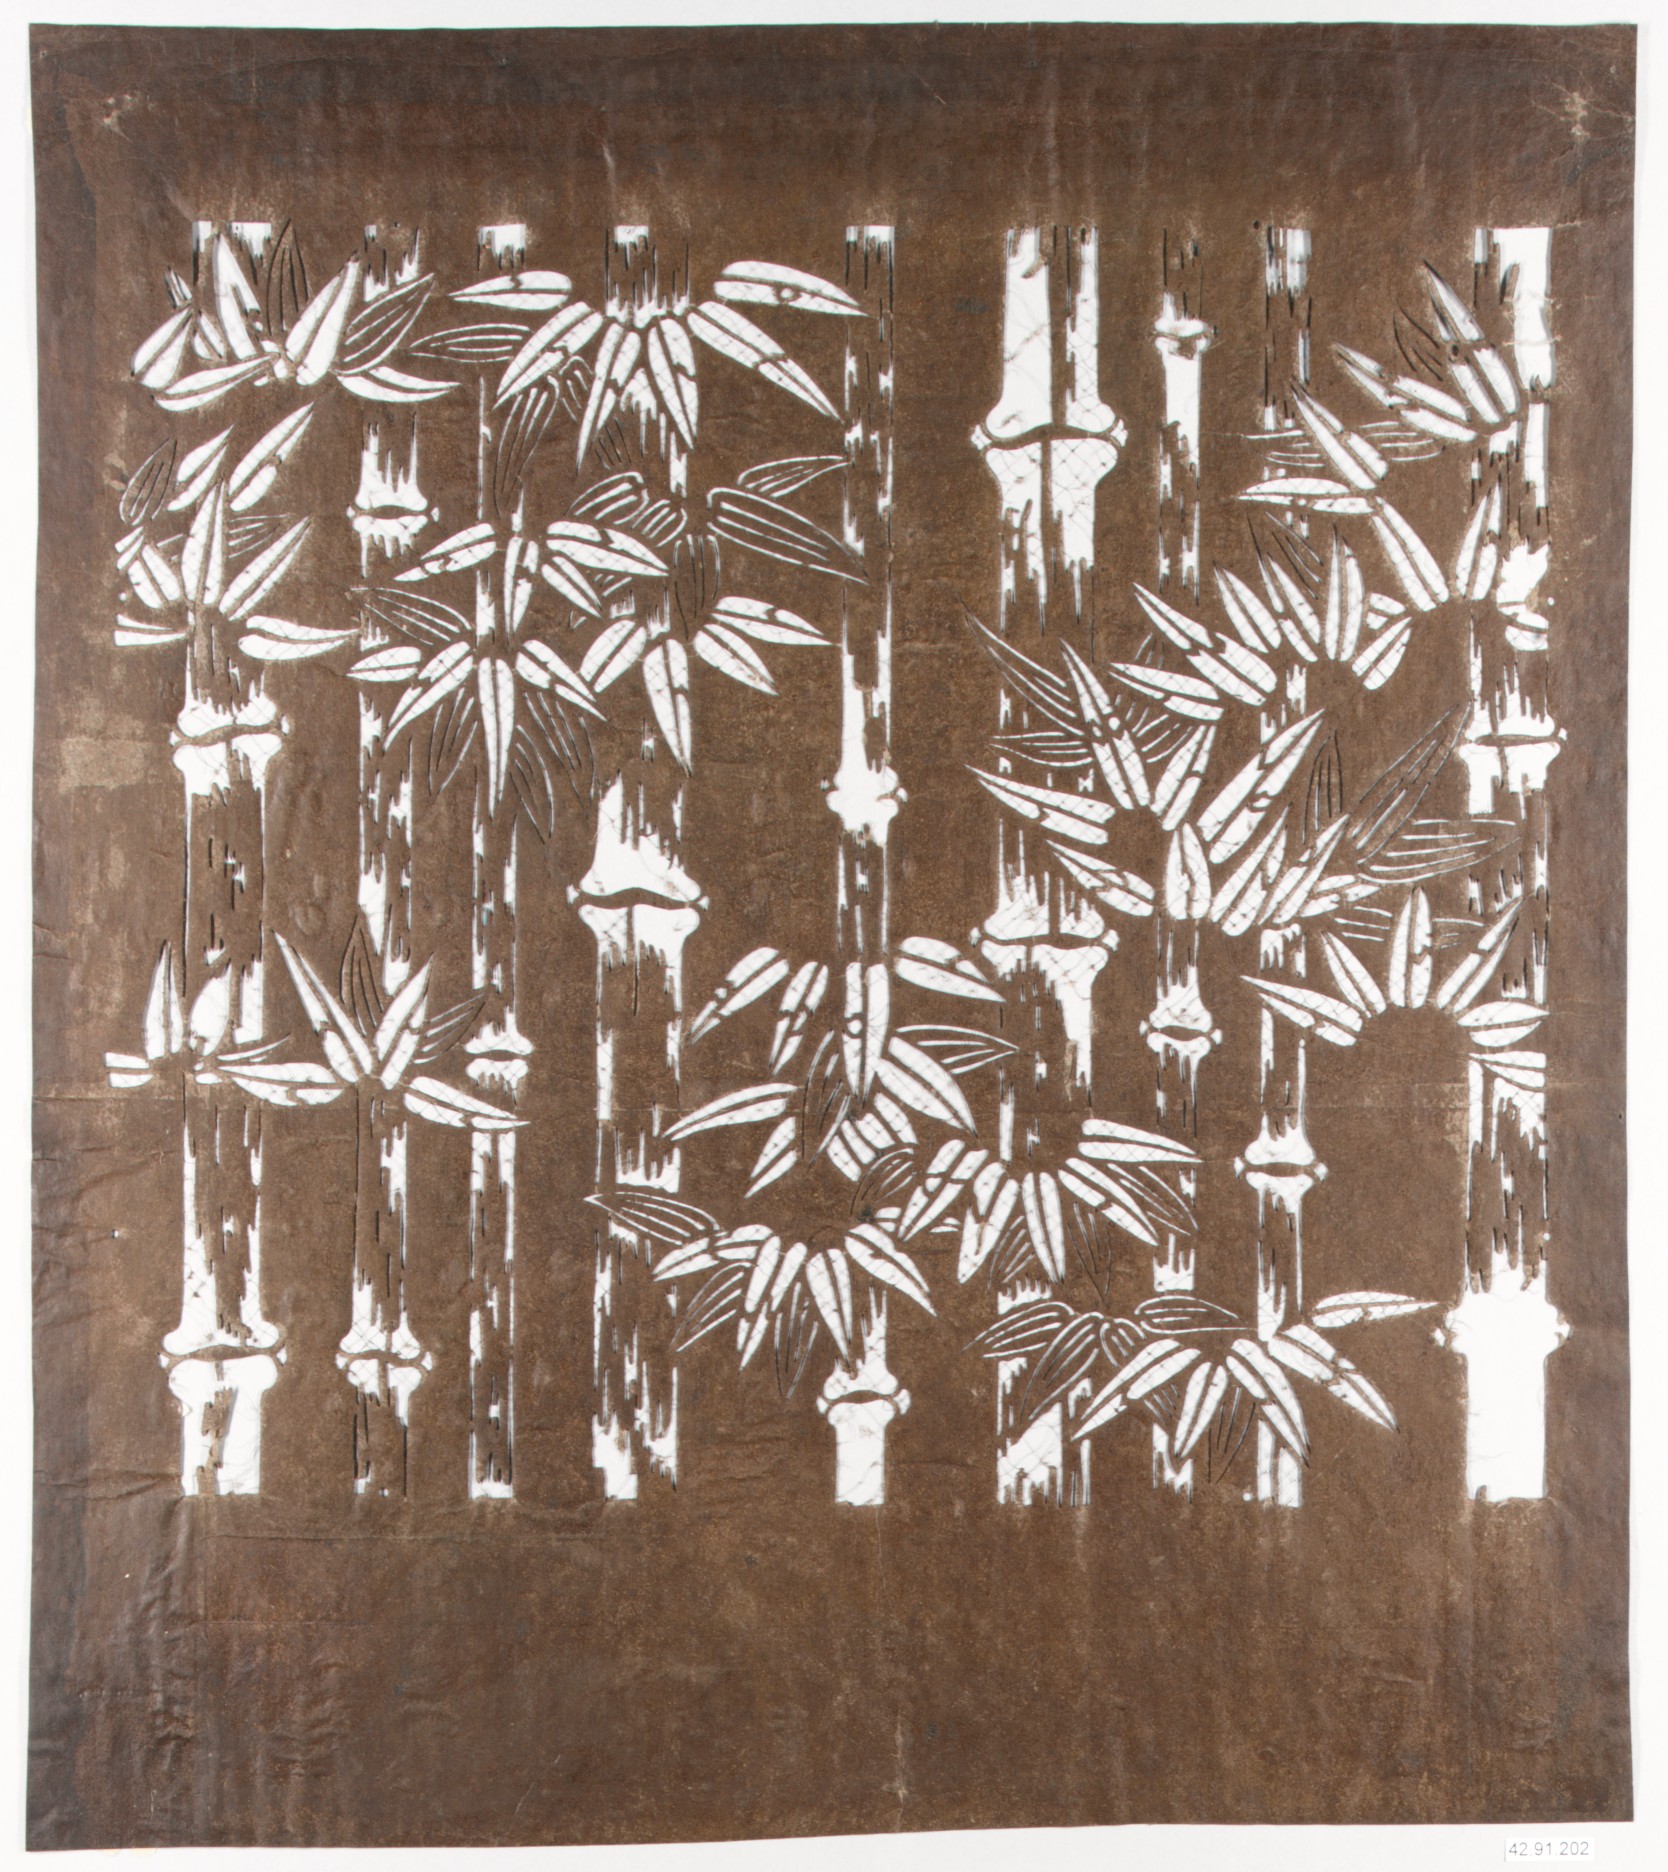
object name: stencil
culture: japanese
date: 1801-1900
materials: paper, silk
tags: bamboo